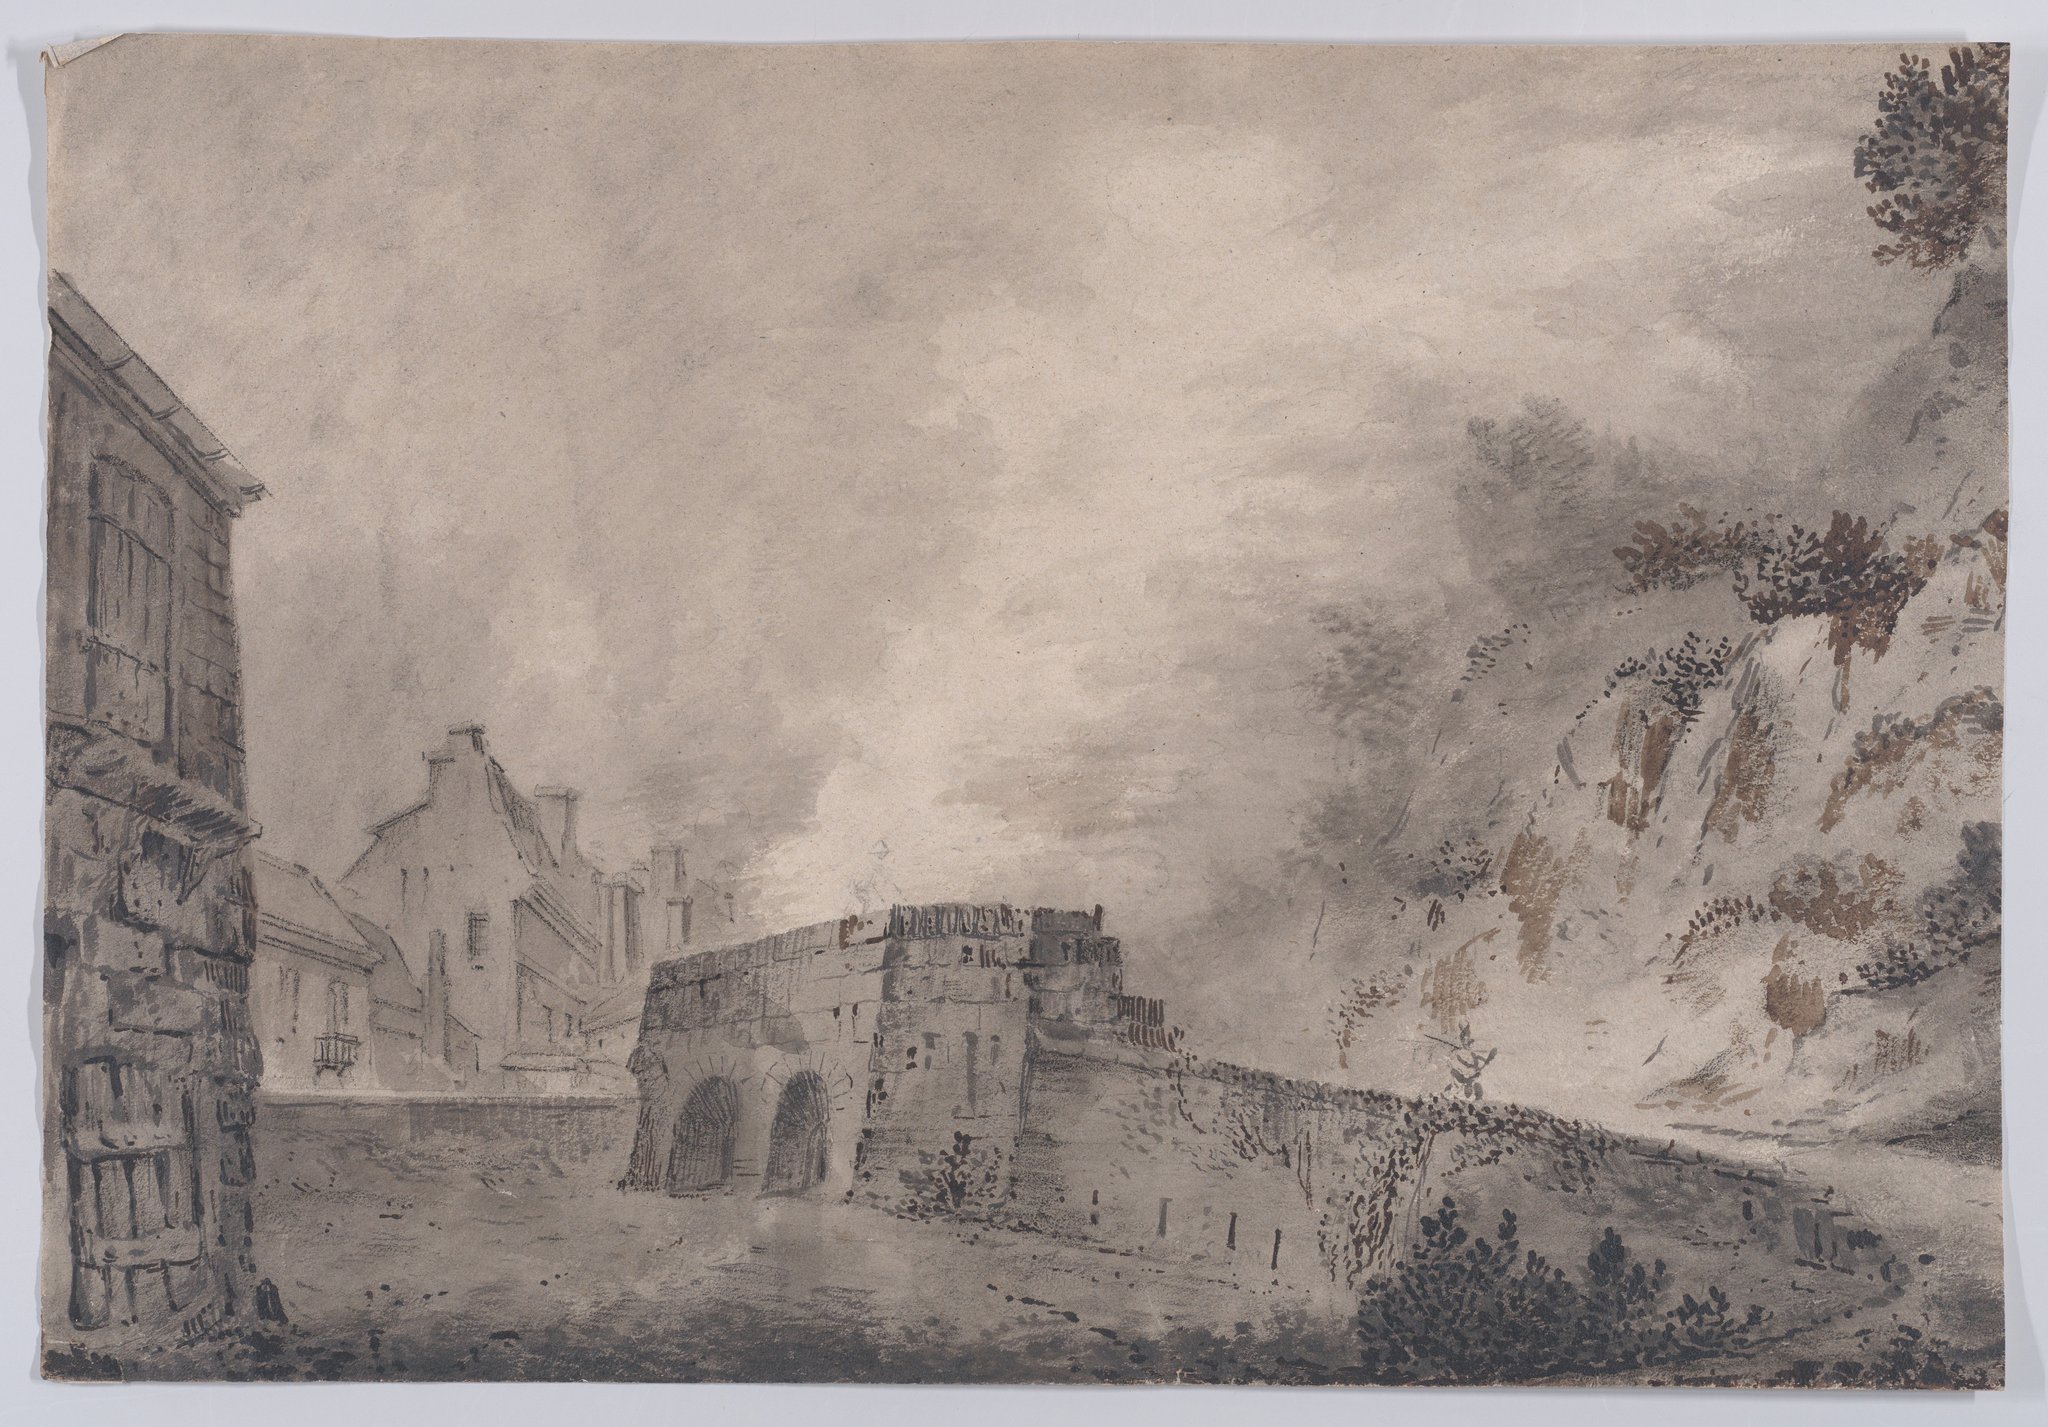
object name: drawing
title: Townscape with a Bridge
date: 1601-1700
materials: chalk, paper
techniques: brush, wash